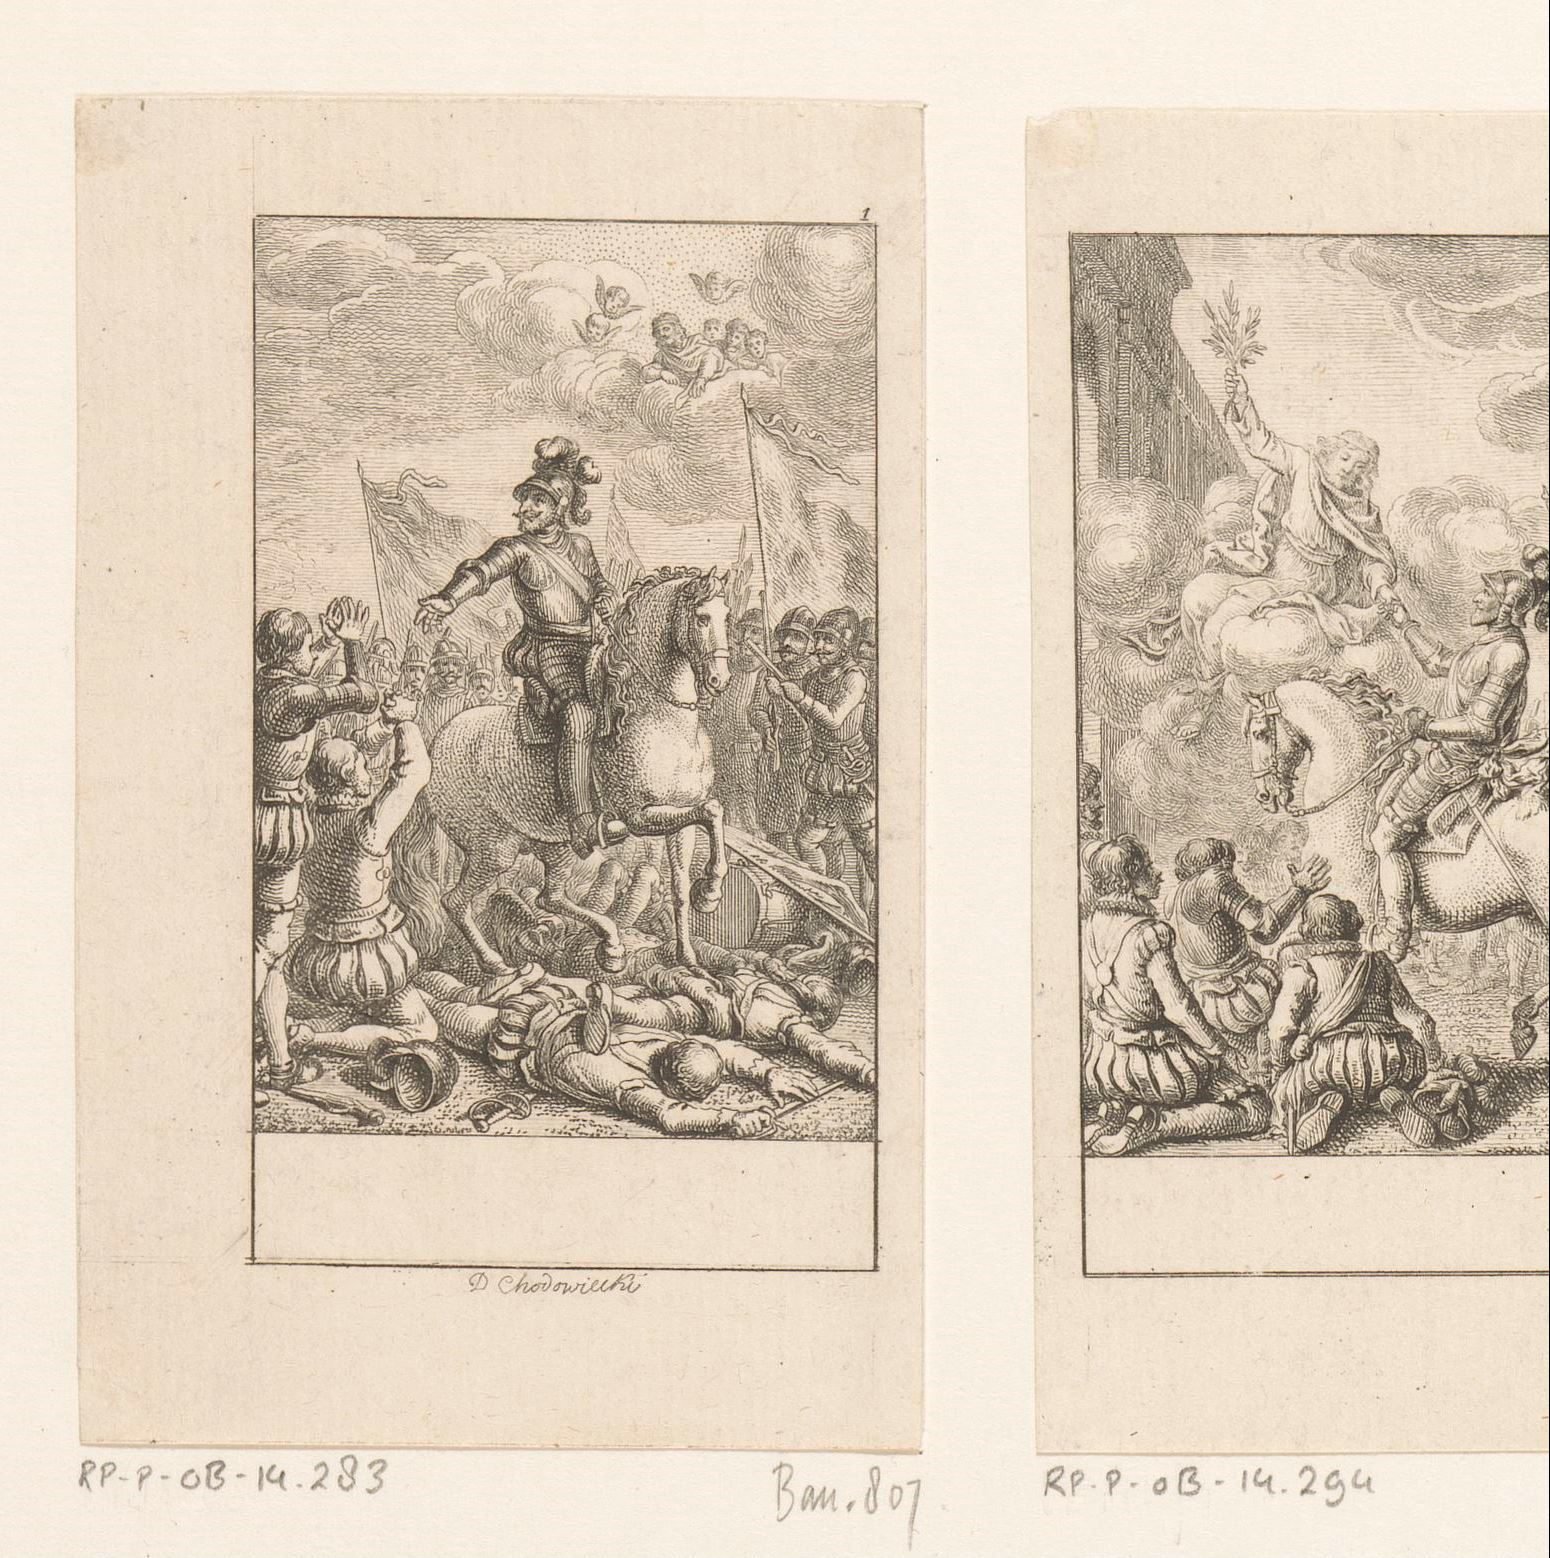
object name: print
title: God kijkt vanaf een wolk toe hoe Hendrik IV van Frankrijk als overwinnaar op zijn tegenstanders staat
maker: daniel nikolaus chodowiecki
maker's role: draughtsman, print maker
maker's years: 1726-1801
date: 1781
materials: paper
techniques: etching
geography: berlin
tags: paris, hendrik iv (koning van frankrijk en navarra), voltaire, equestrian state-portrait, other representations ~ god the father, armour, historical persons, battle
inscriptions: collector's mark: Lugt 2228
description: Deze prent behoort tot een serie van twaalf prenten, vervaardigd voor de geschriften van Voltaire. Prent gebruikt voor: Almanac historique généalogique pour l'année 1782. A Berlin. Berlijn: L'Academie, 1781.